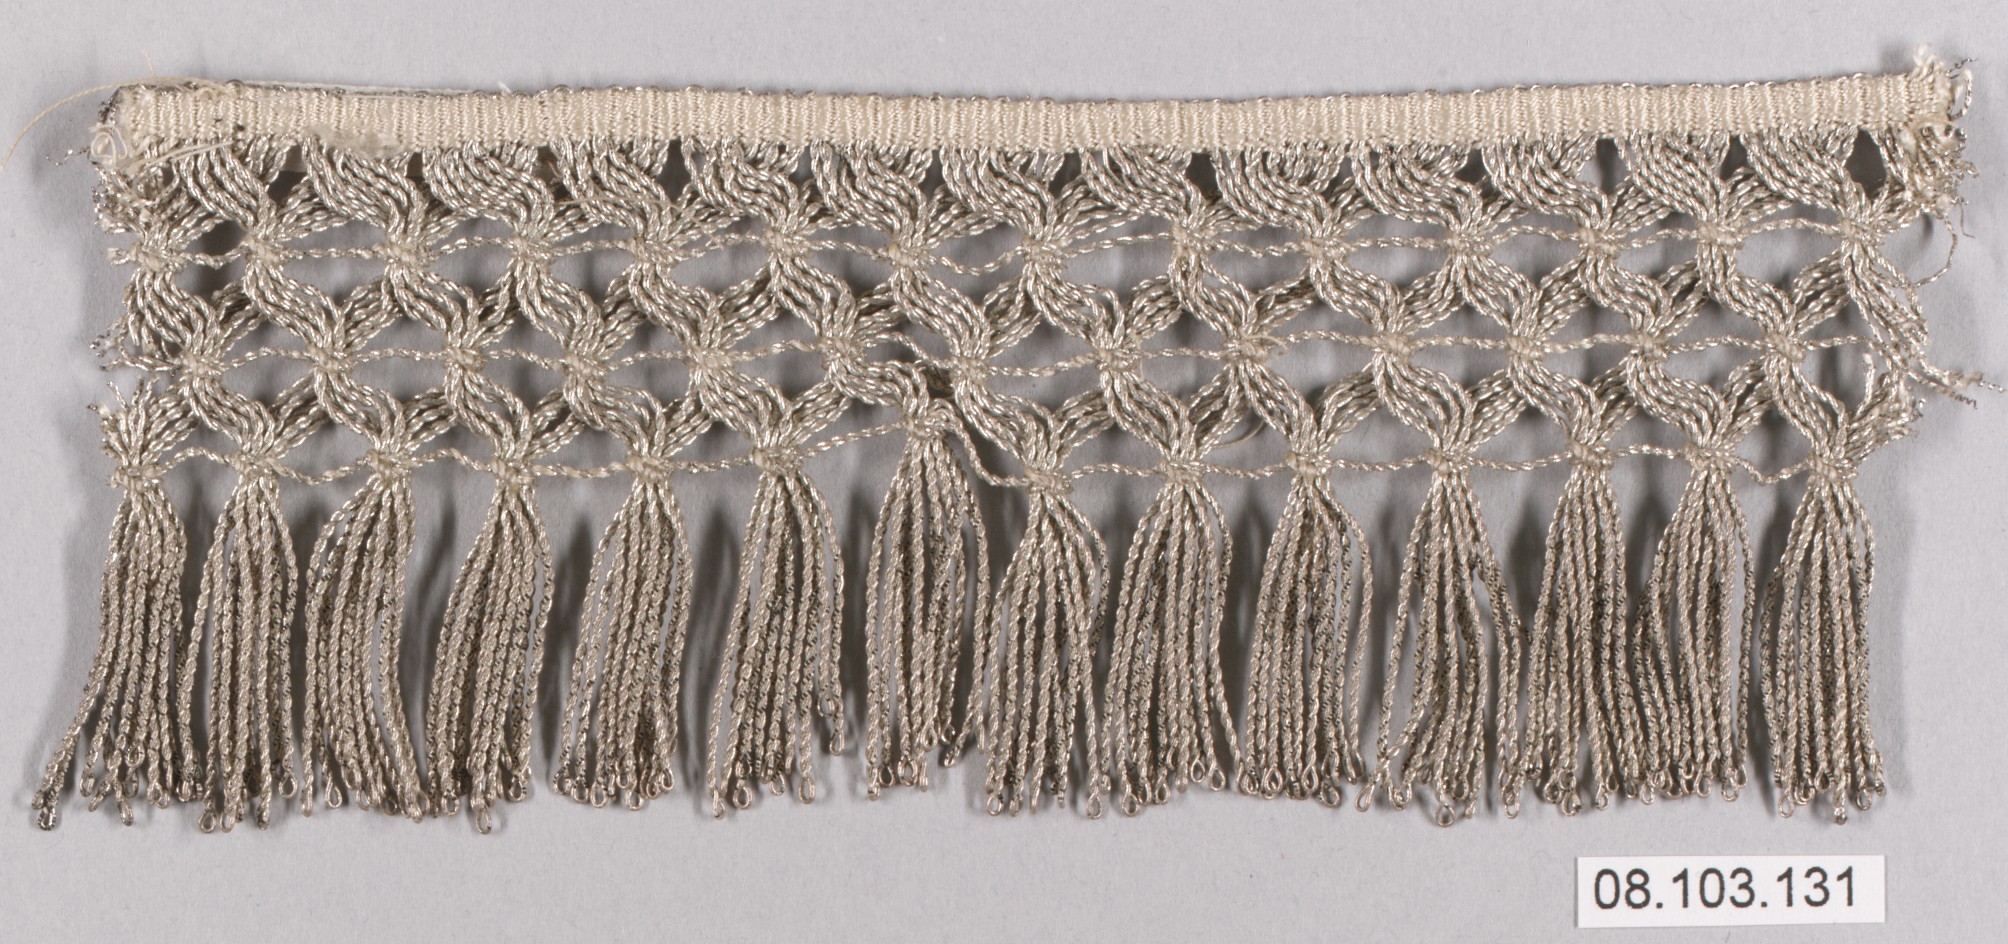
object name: fringe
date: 1801-1900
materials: metal thread